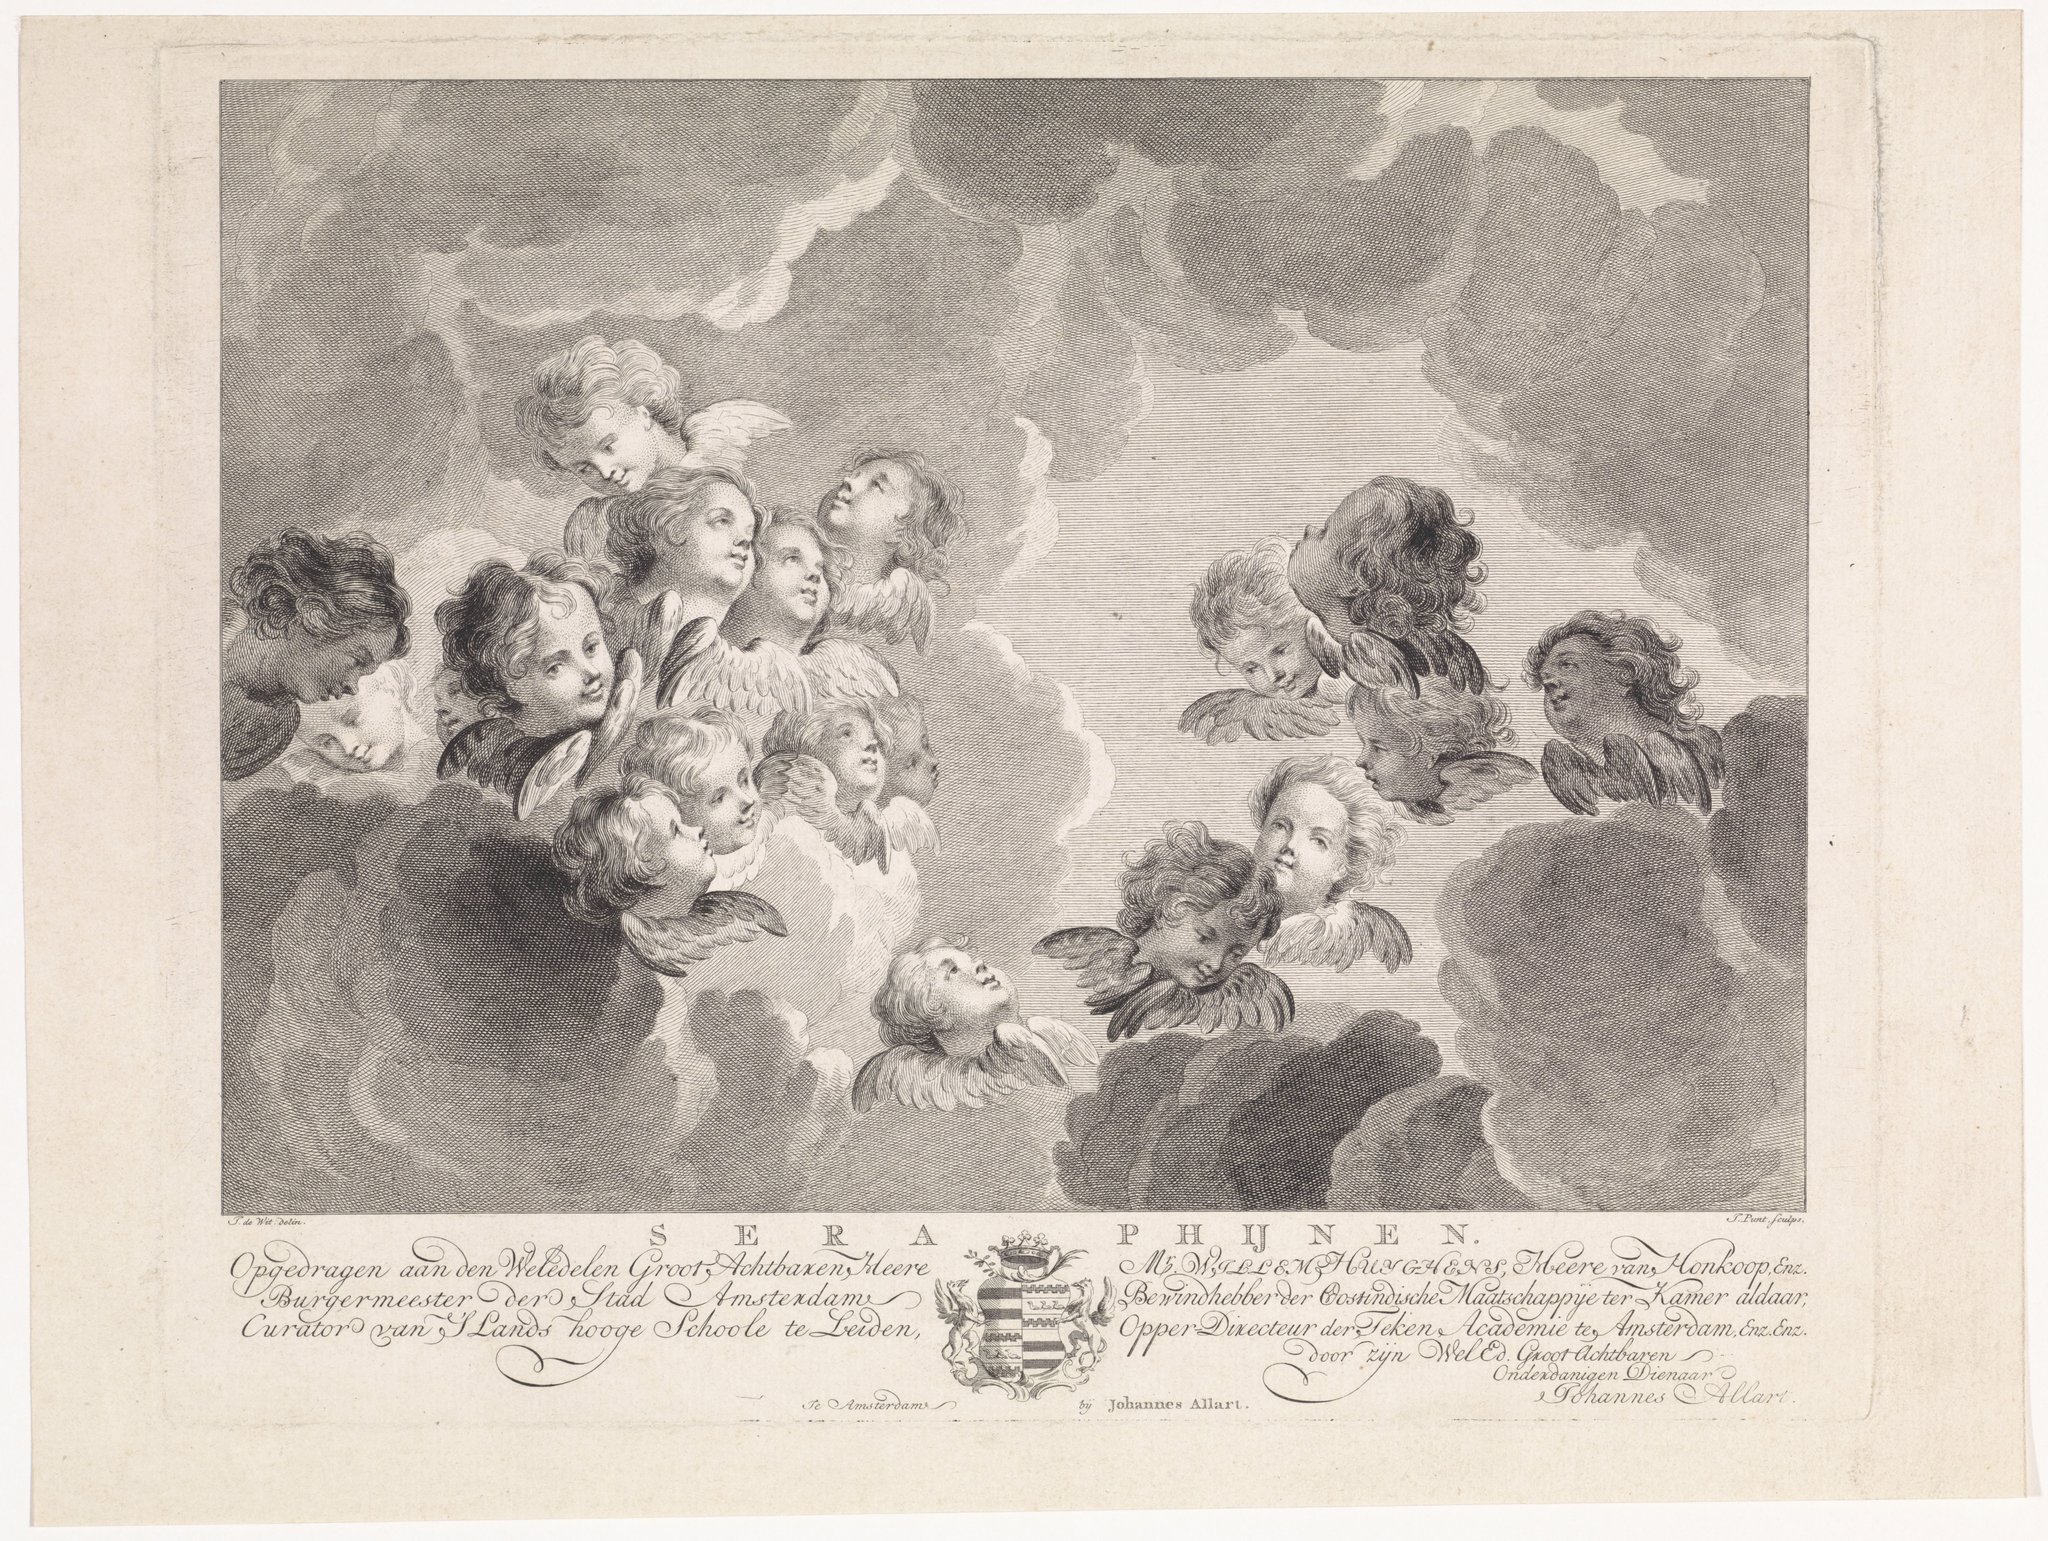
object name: print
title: Cherubijnen in de wolken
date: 1768-1779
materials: paper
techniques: engraving, etching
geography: amsterdam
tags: cherubs, i.e. children's heads with wings, armorial bearing, heraldry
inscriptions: collector's mark: Lugt 2228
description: In de marge een drieregelige opdracht in het Nederlands.